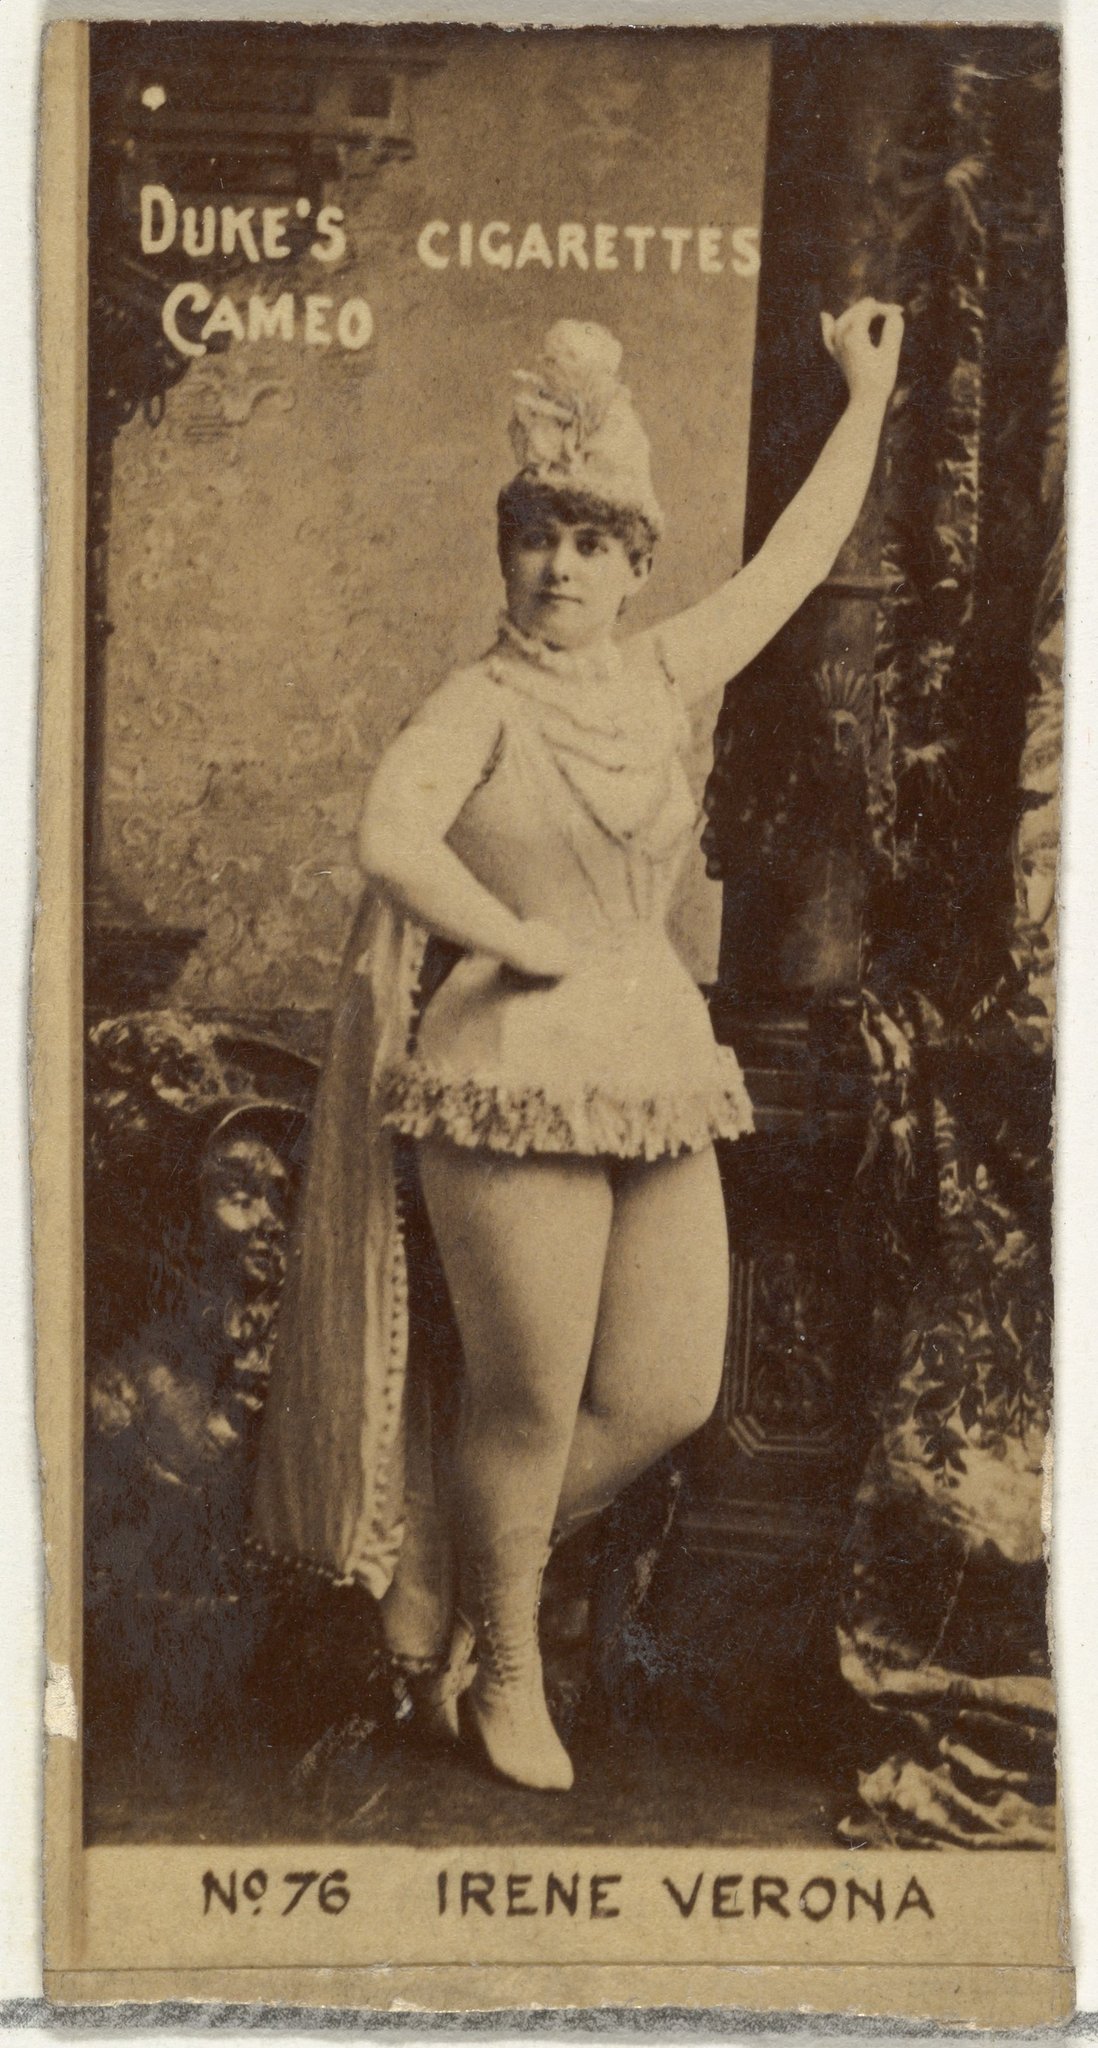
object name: photograph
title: Card Number 76, Irene Verona, from the Actors and Actresses series (N145-4) issued by Duke Sons & Co. to promote Cameo Cigarettes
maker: w. duke, sons & co.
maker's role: publisher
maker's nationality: american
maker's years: 1870-1920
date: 1880-1889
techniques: albumen silver print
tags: portraits,women,actresses